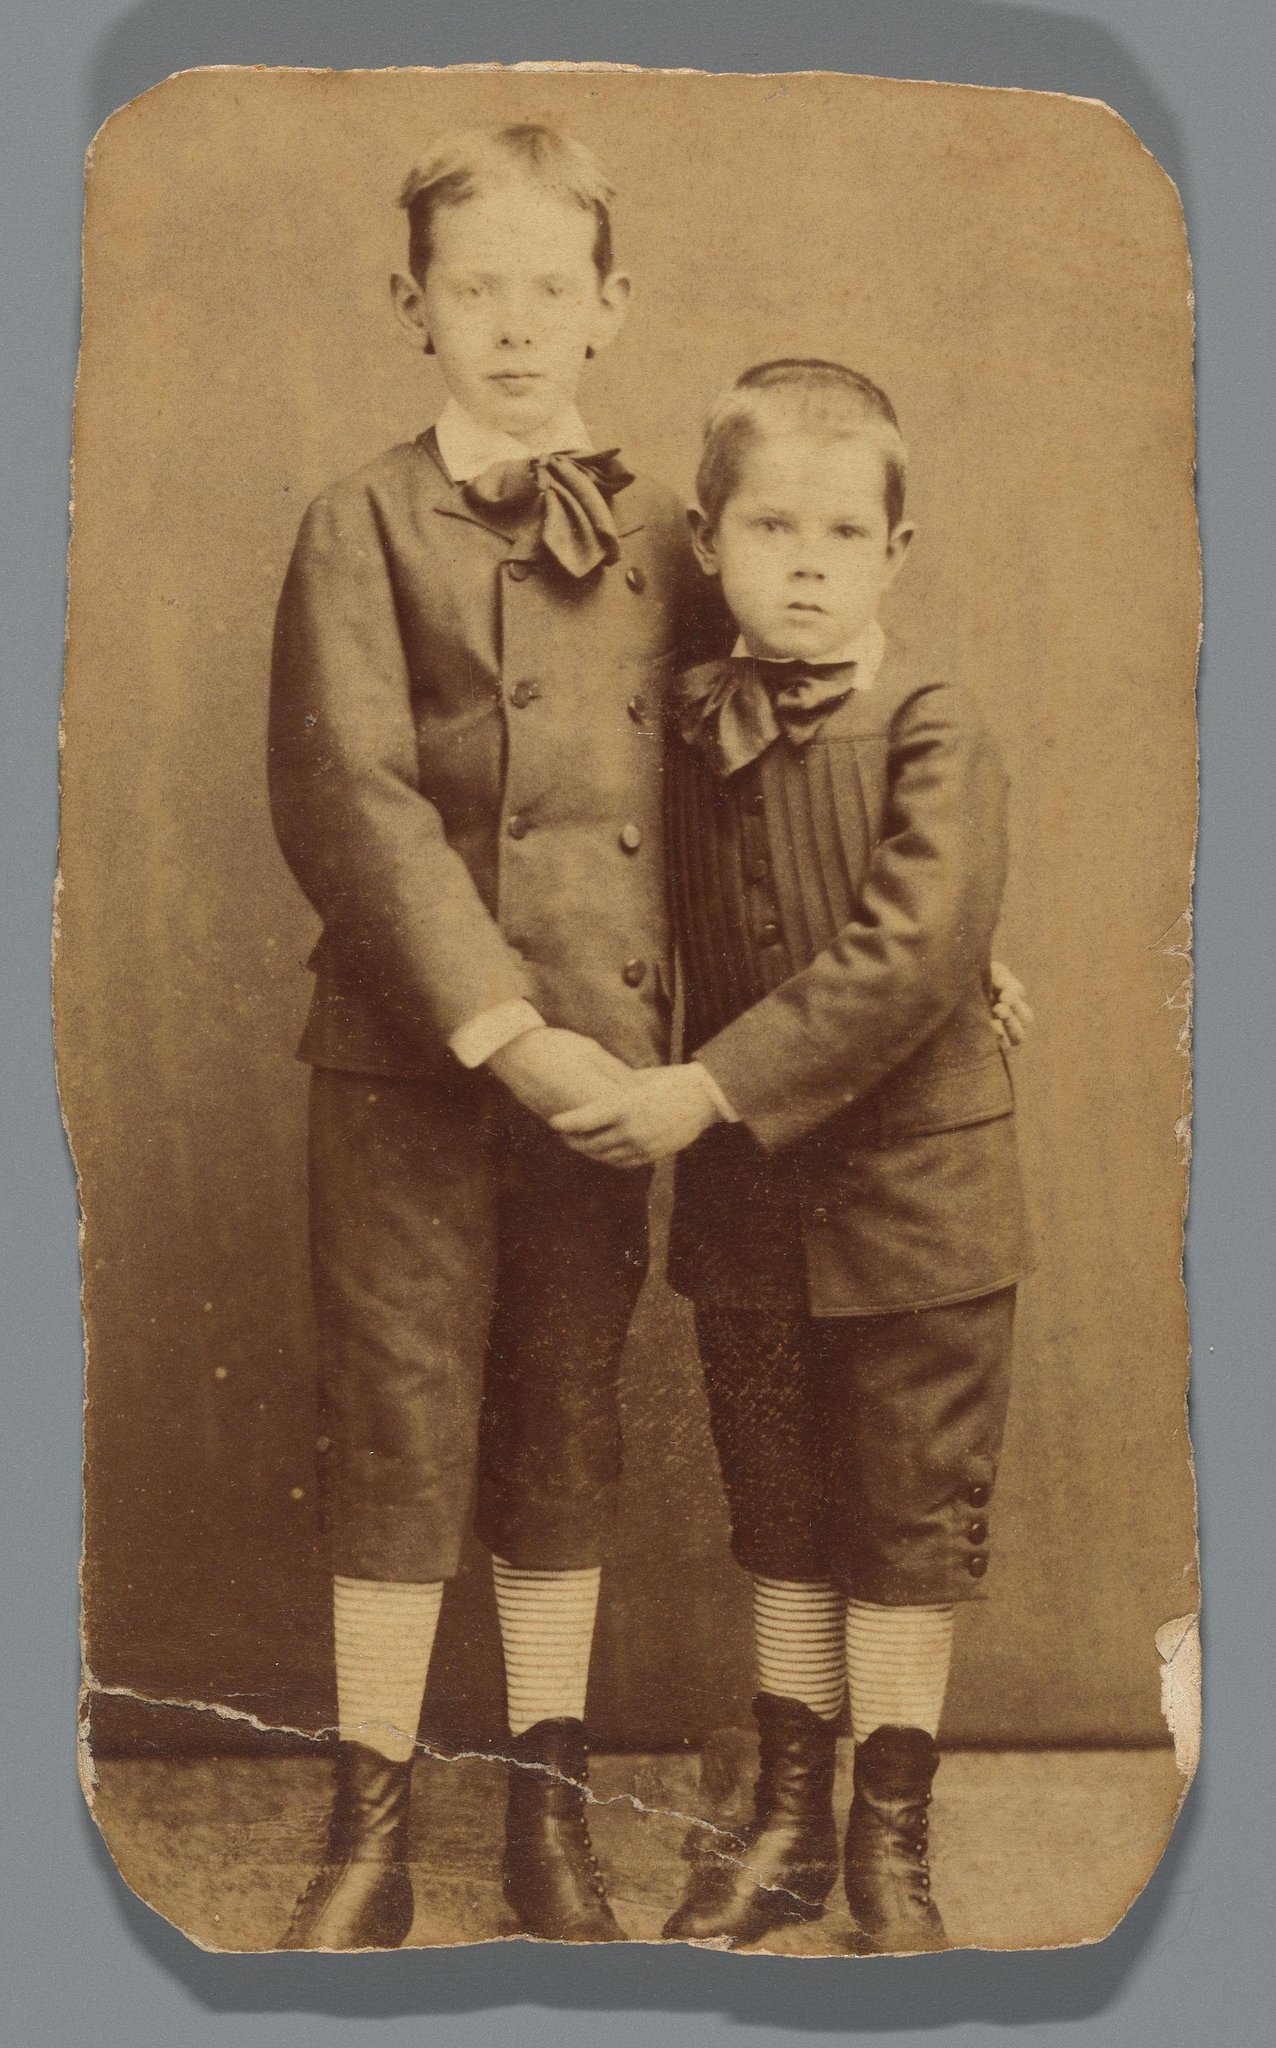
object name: photograph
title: Studioportret van Karel Frederik van den Berg en Hendrik Herman van den Berg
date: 1880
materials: cardboard, photographic support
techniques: albumen print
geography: the hague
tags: hendrik herman van den berg, batavia, karel frederik van den berg, the hague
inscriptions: name: ‘oom Karel en vader’, name: ‘DE LAVIETER & Co / PHOTOGRAPHES DE S. M. LE ROI, / DE S. A. R. LE PRINCE D' ORANGE / ET DE S. A. R. MADAME LA PRINCESSE HENRI / DES PAYS-BAS. / 2. Willemstraat.-LA HAYE.’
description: Twee staande jongens die elkaars hand vasthouden.